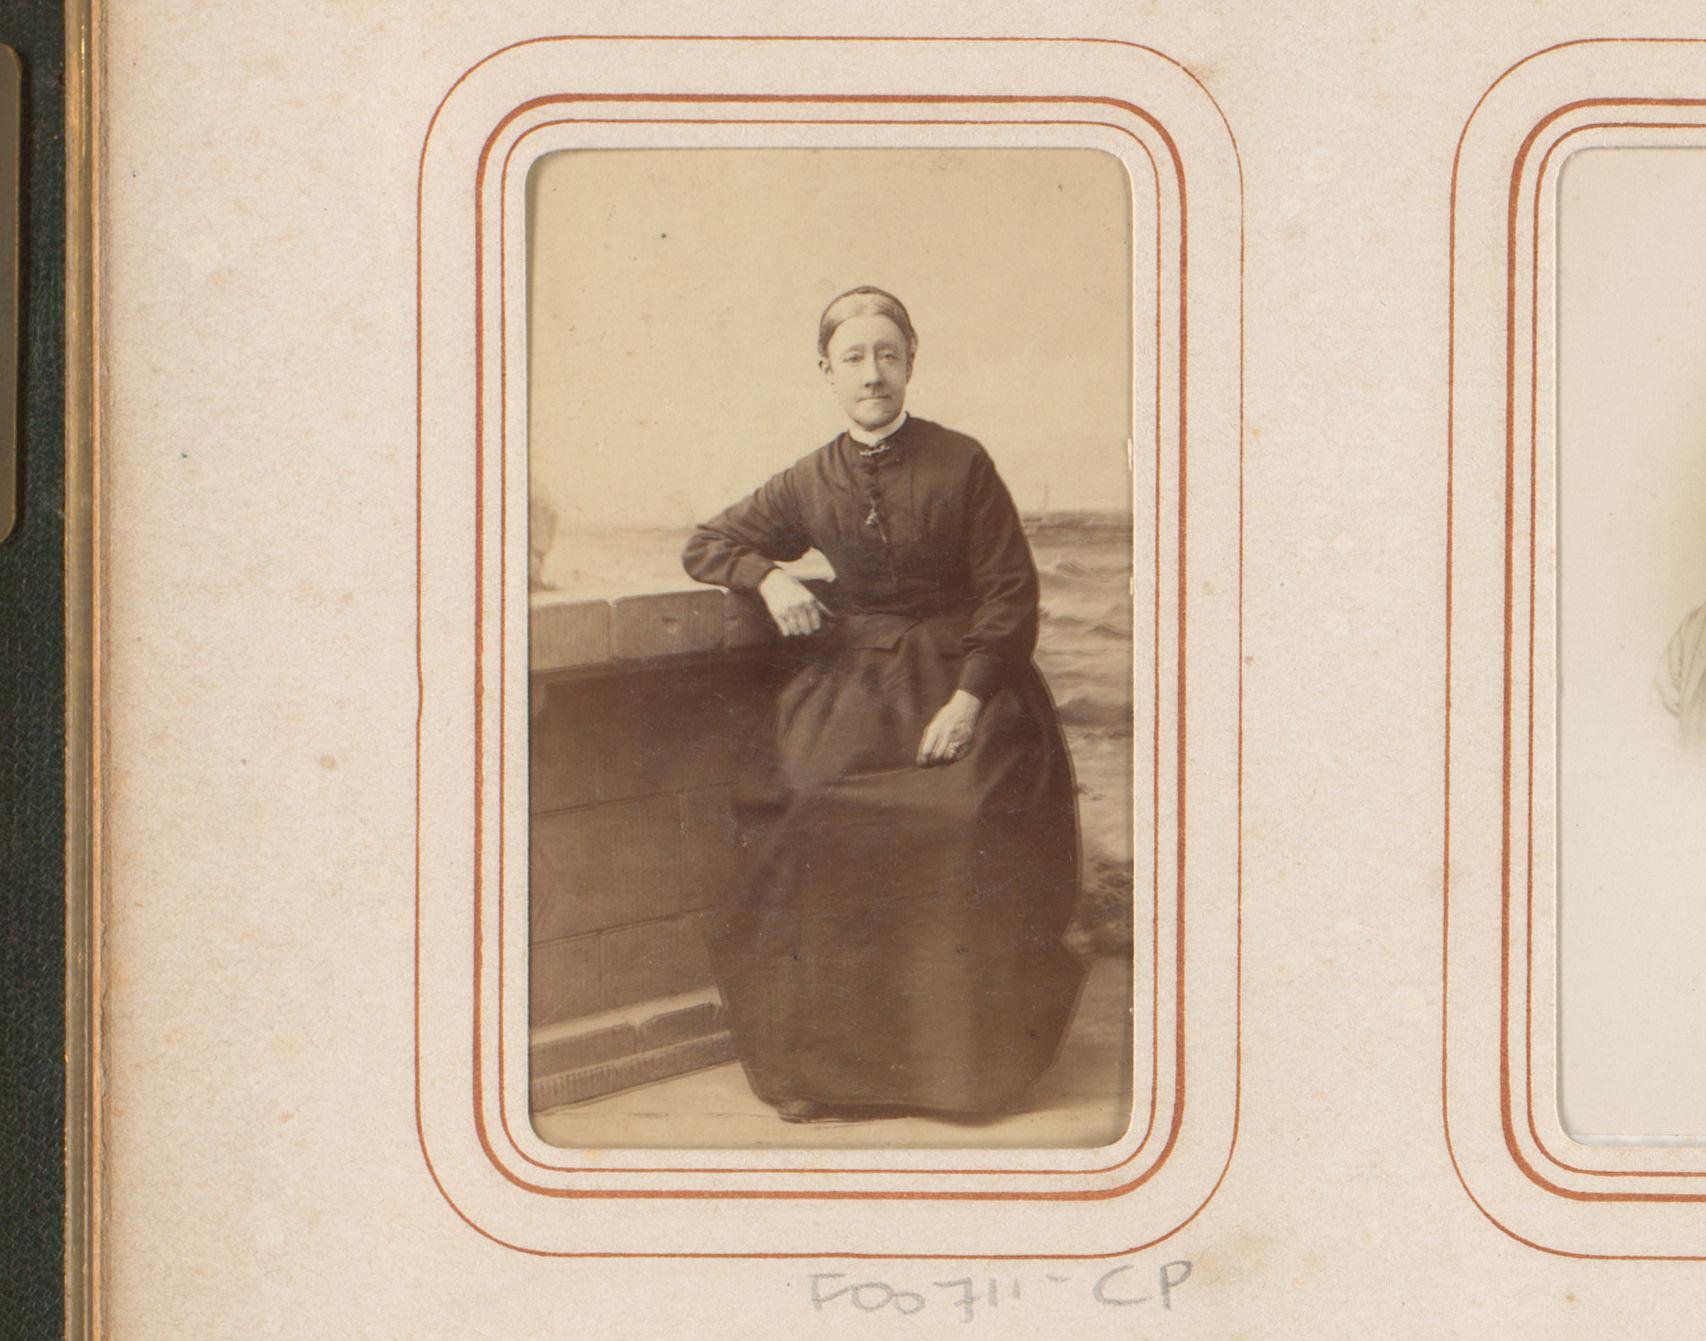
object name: album leaf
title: Portret van een zittende vrouw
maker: cornelis johannes lodewicus vermeulen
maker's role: fotograaf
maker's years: 1861-1936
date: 1888-1896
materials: cardboard, photographic support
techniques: albumen print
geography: netherlands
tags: historical persons - bb - woman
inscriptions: inscription: ‘Amsterdam, Heerenstraat 6, Heiligenweg hoek Singel’